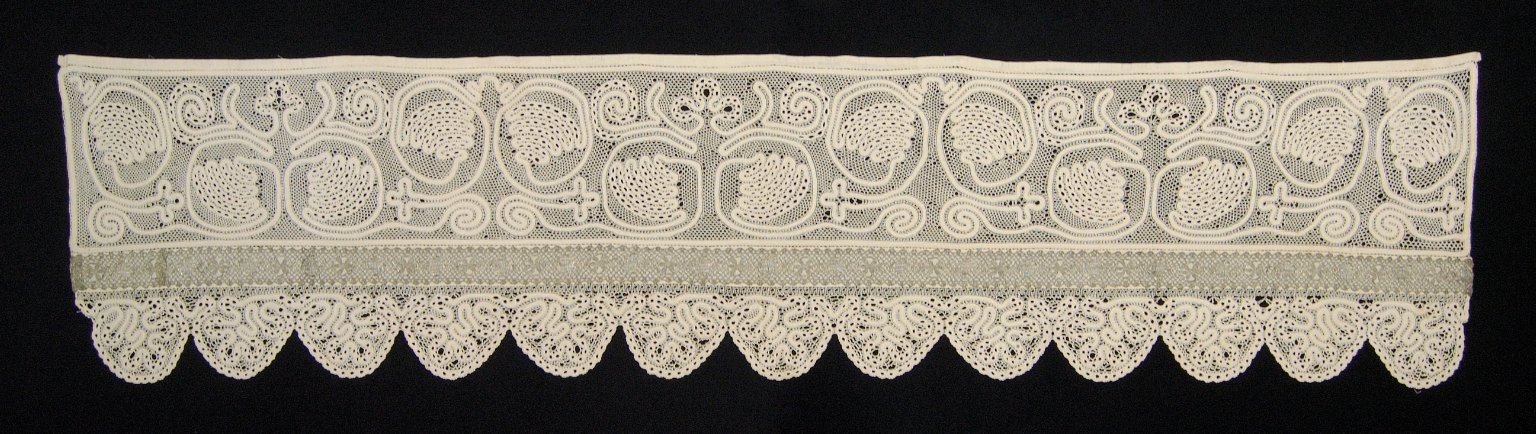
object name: textile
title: Bed curtain border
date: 1800-1850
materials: linen